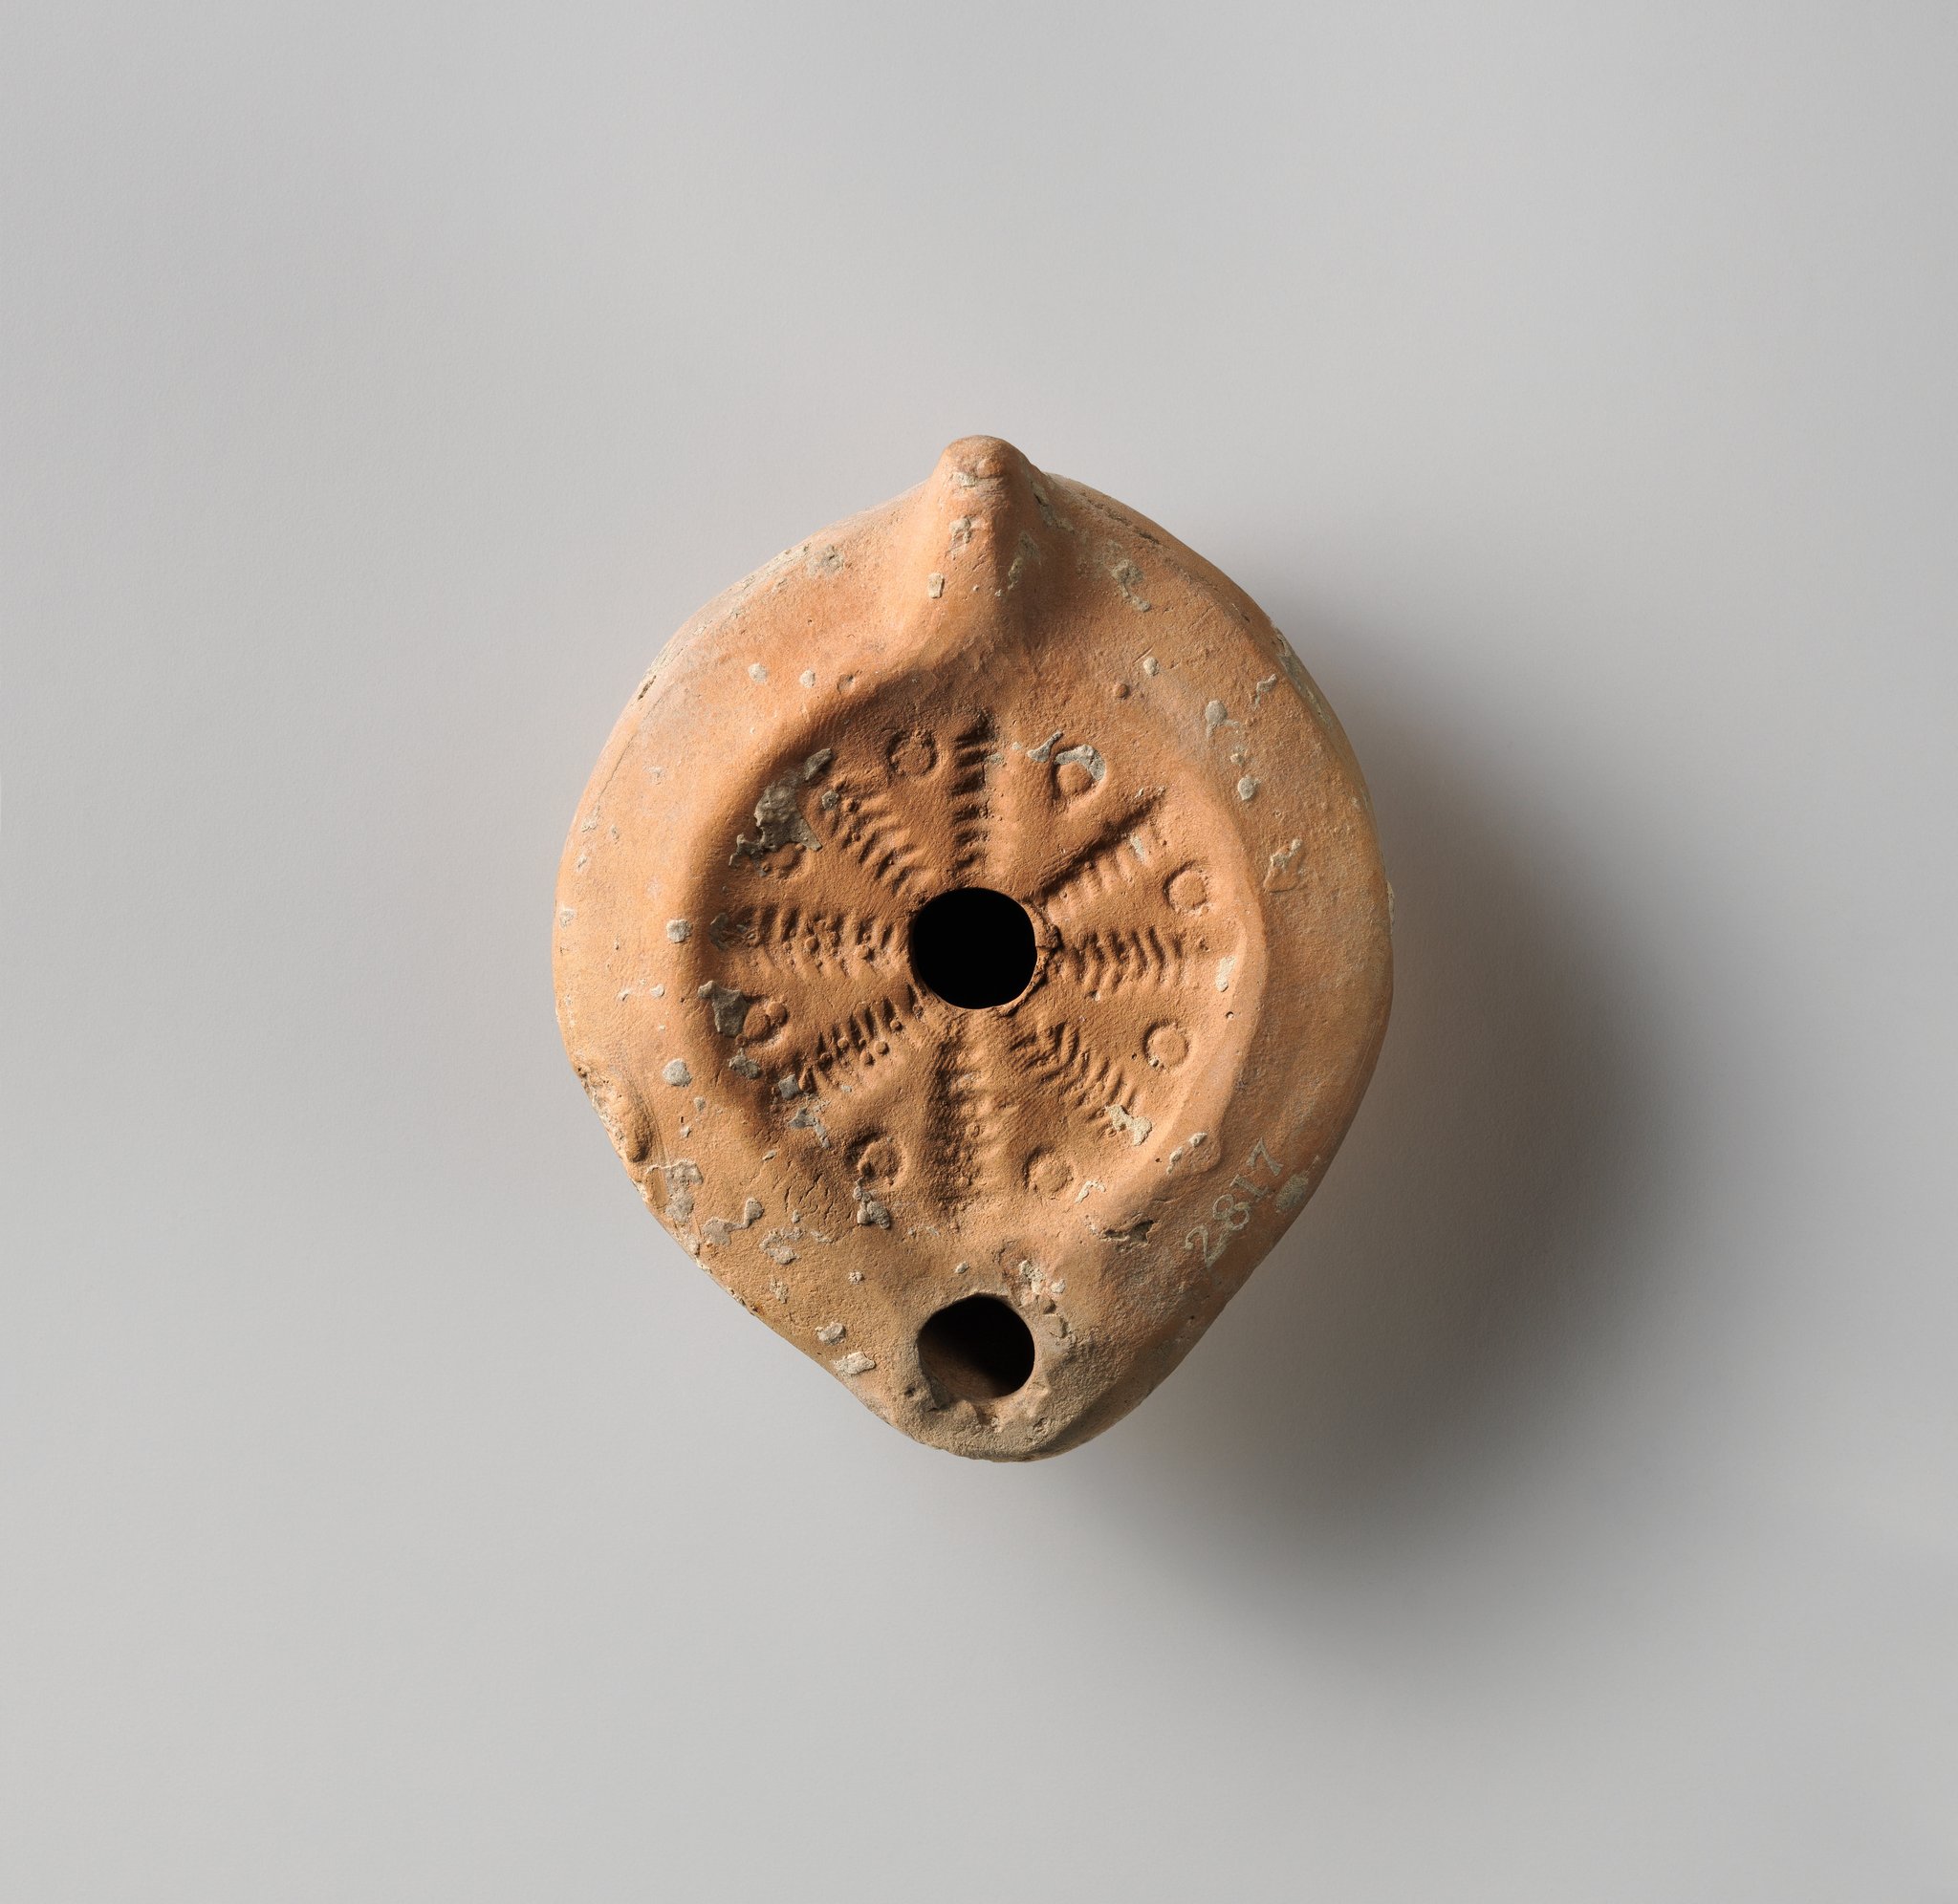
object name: lamp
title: Terracotta oil lamp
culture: roman, cypriot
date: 401-600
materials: terracotta